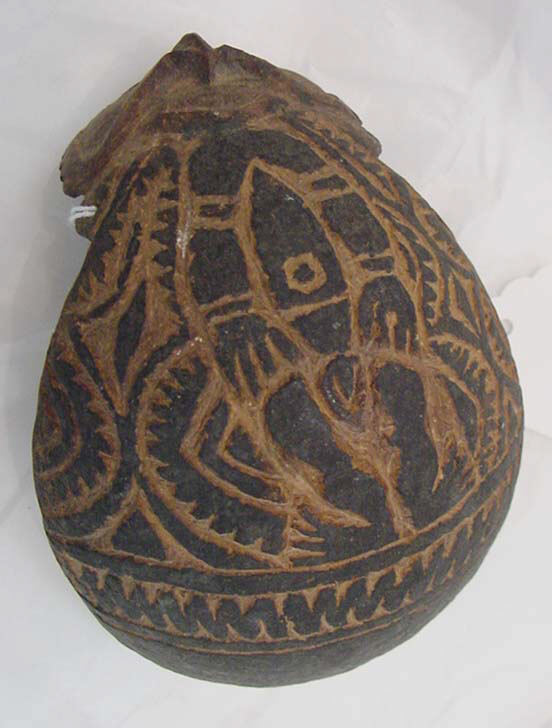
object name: phallocrypt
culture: oceanic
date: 1801-1900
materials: pigment